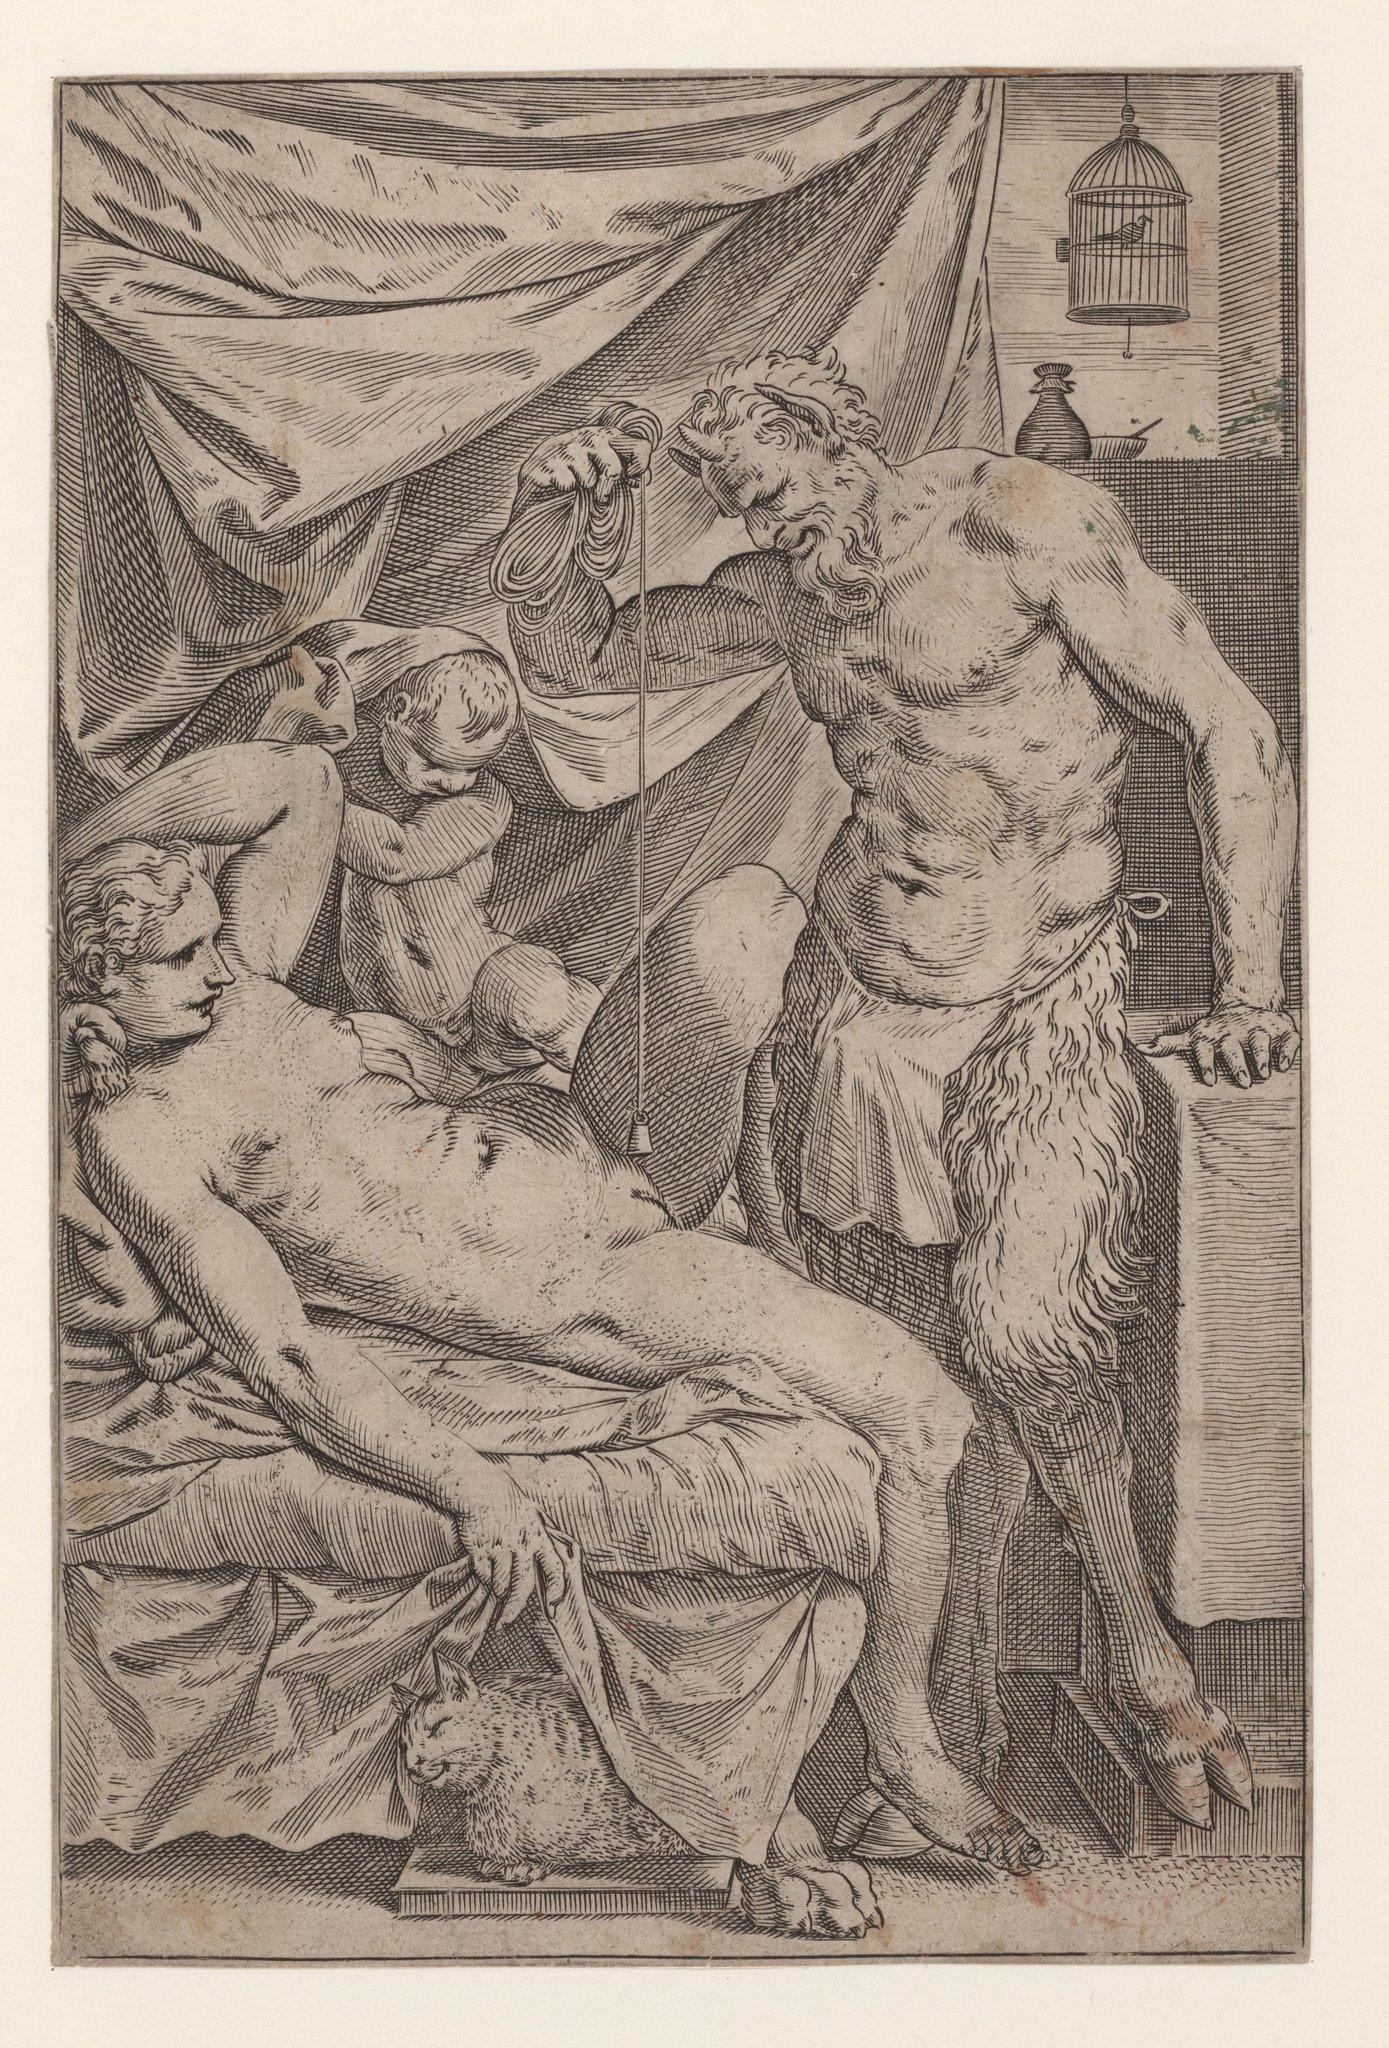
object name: print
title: Nimf en sater met schietlood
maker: agostino carracci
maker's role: draughtsman, painter, print maker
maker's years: 1557-1602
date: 1590-1595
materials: paper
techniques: engraving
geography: italy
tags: fathoming, sounding (+ variant), nymphs (in general); 'ninfe in commune' (ripa), satyr(s) (in general)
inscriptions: collector's mark: Lugt 240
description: Een naakte nimf ligt op een bed. Een sater staat naast het bed en laat een schietlood bij de schaamstreek van de nimf pendelen. Een putto kijkt van achter een gordijn toe. Onder het bed ligt een spinnende kat. In het venster hangt een vogelkooi met een vogel.